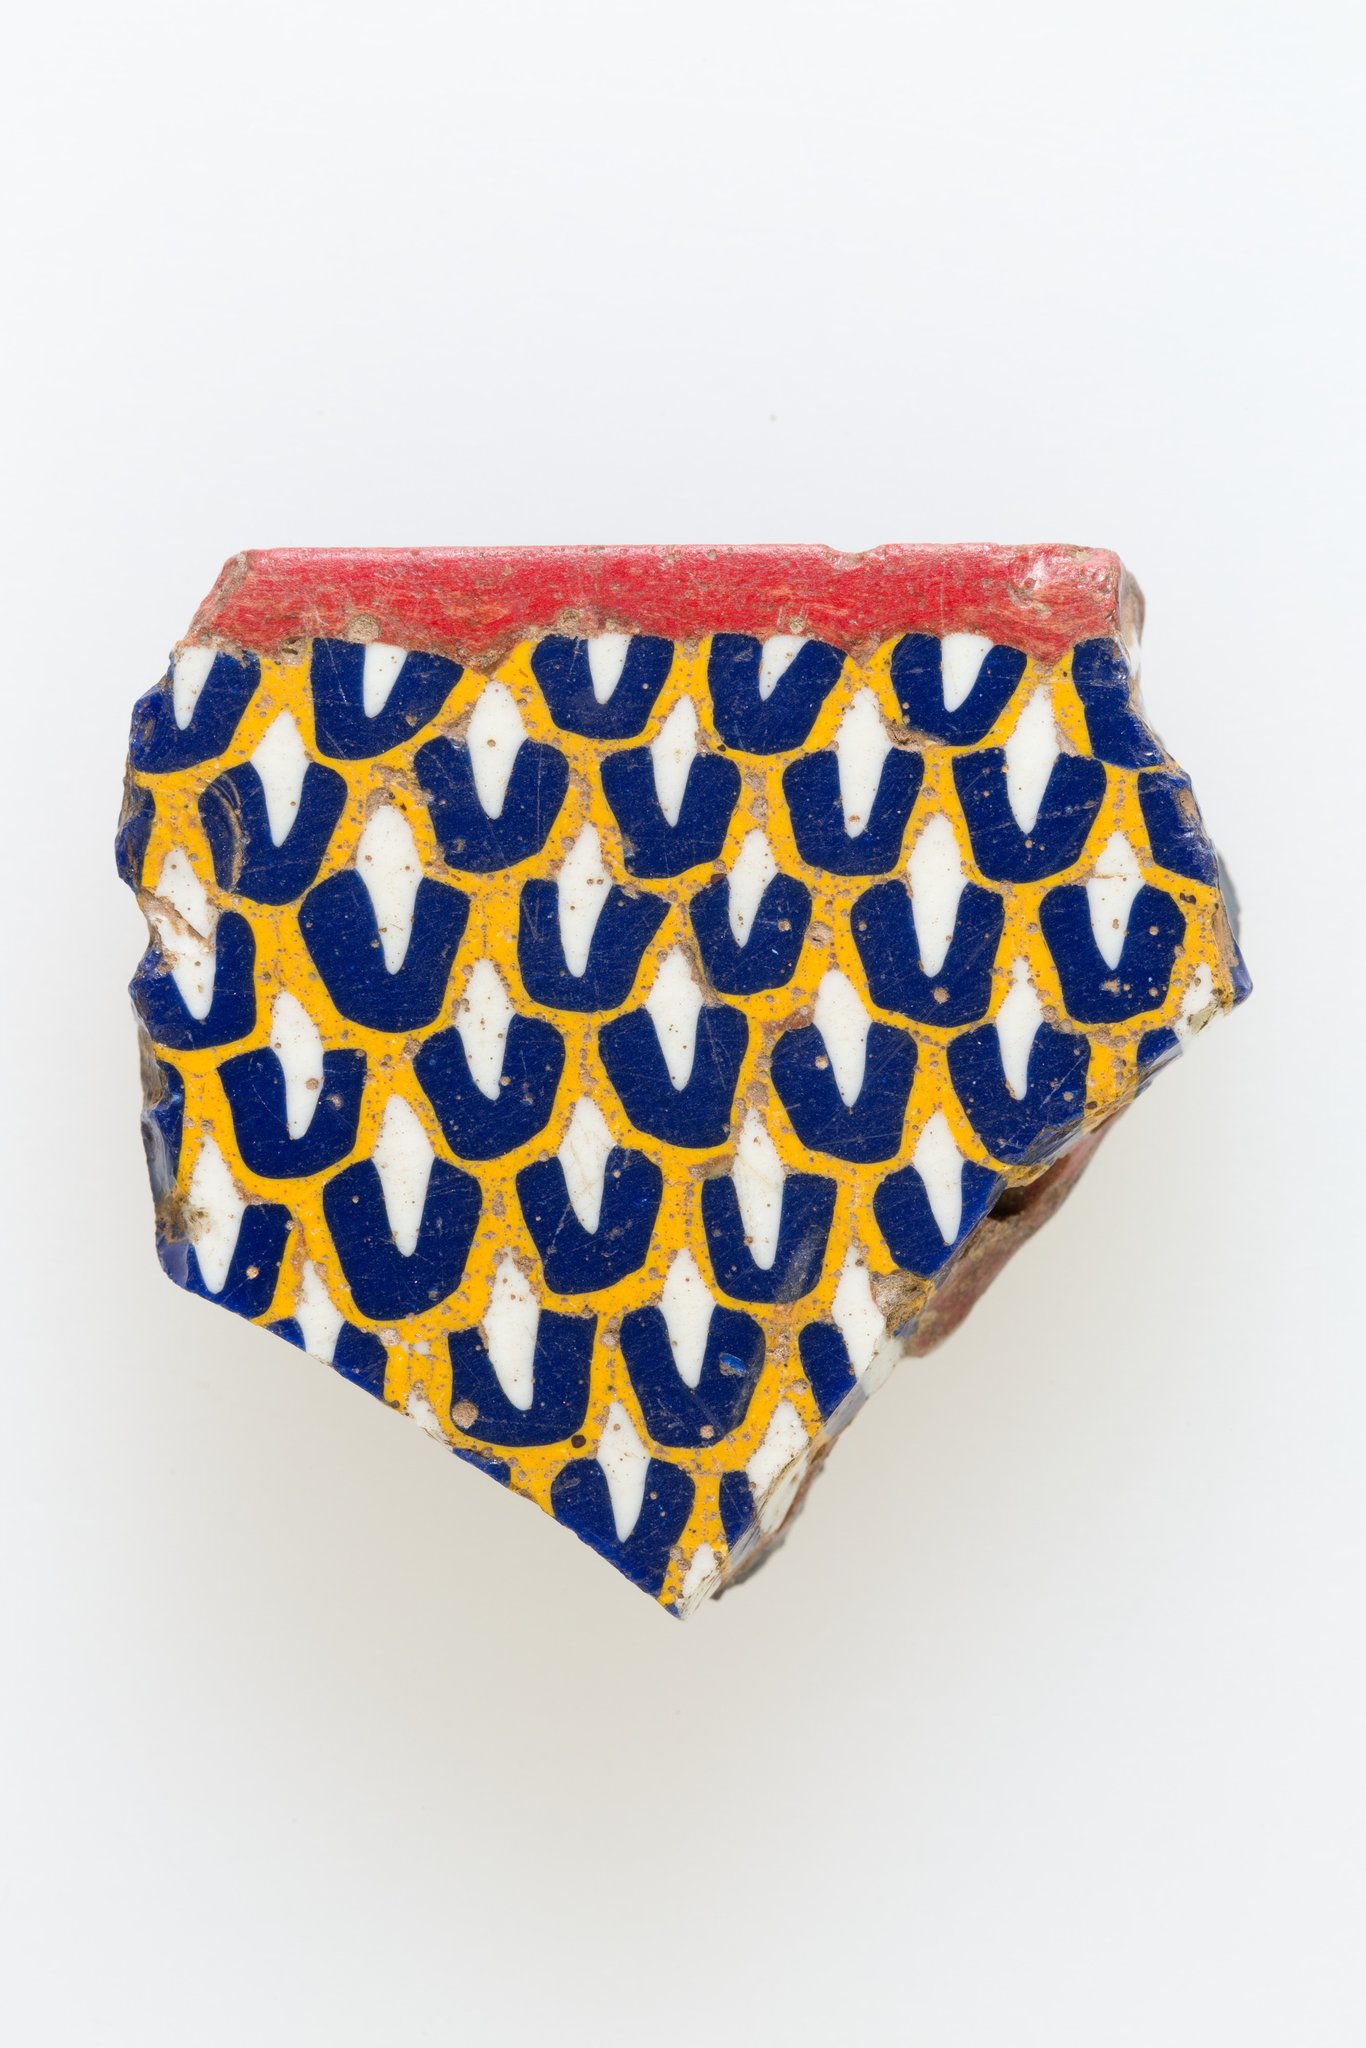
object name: inlay, feather pattern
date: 200 BCE-100 CE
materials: glass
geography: egypt